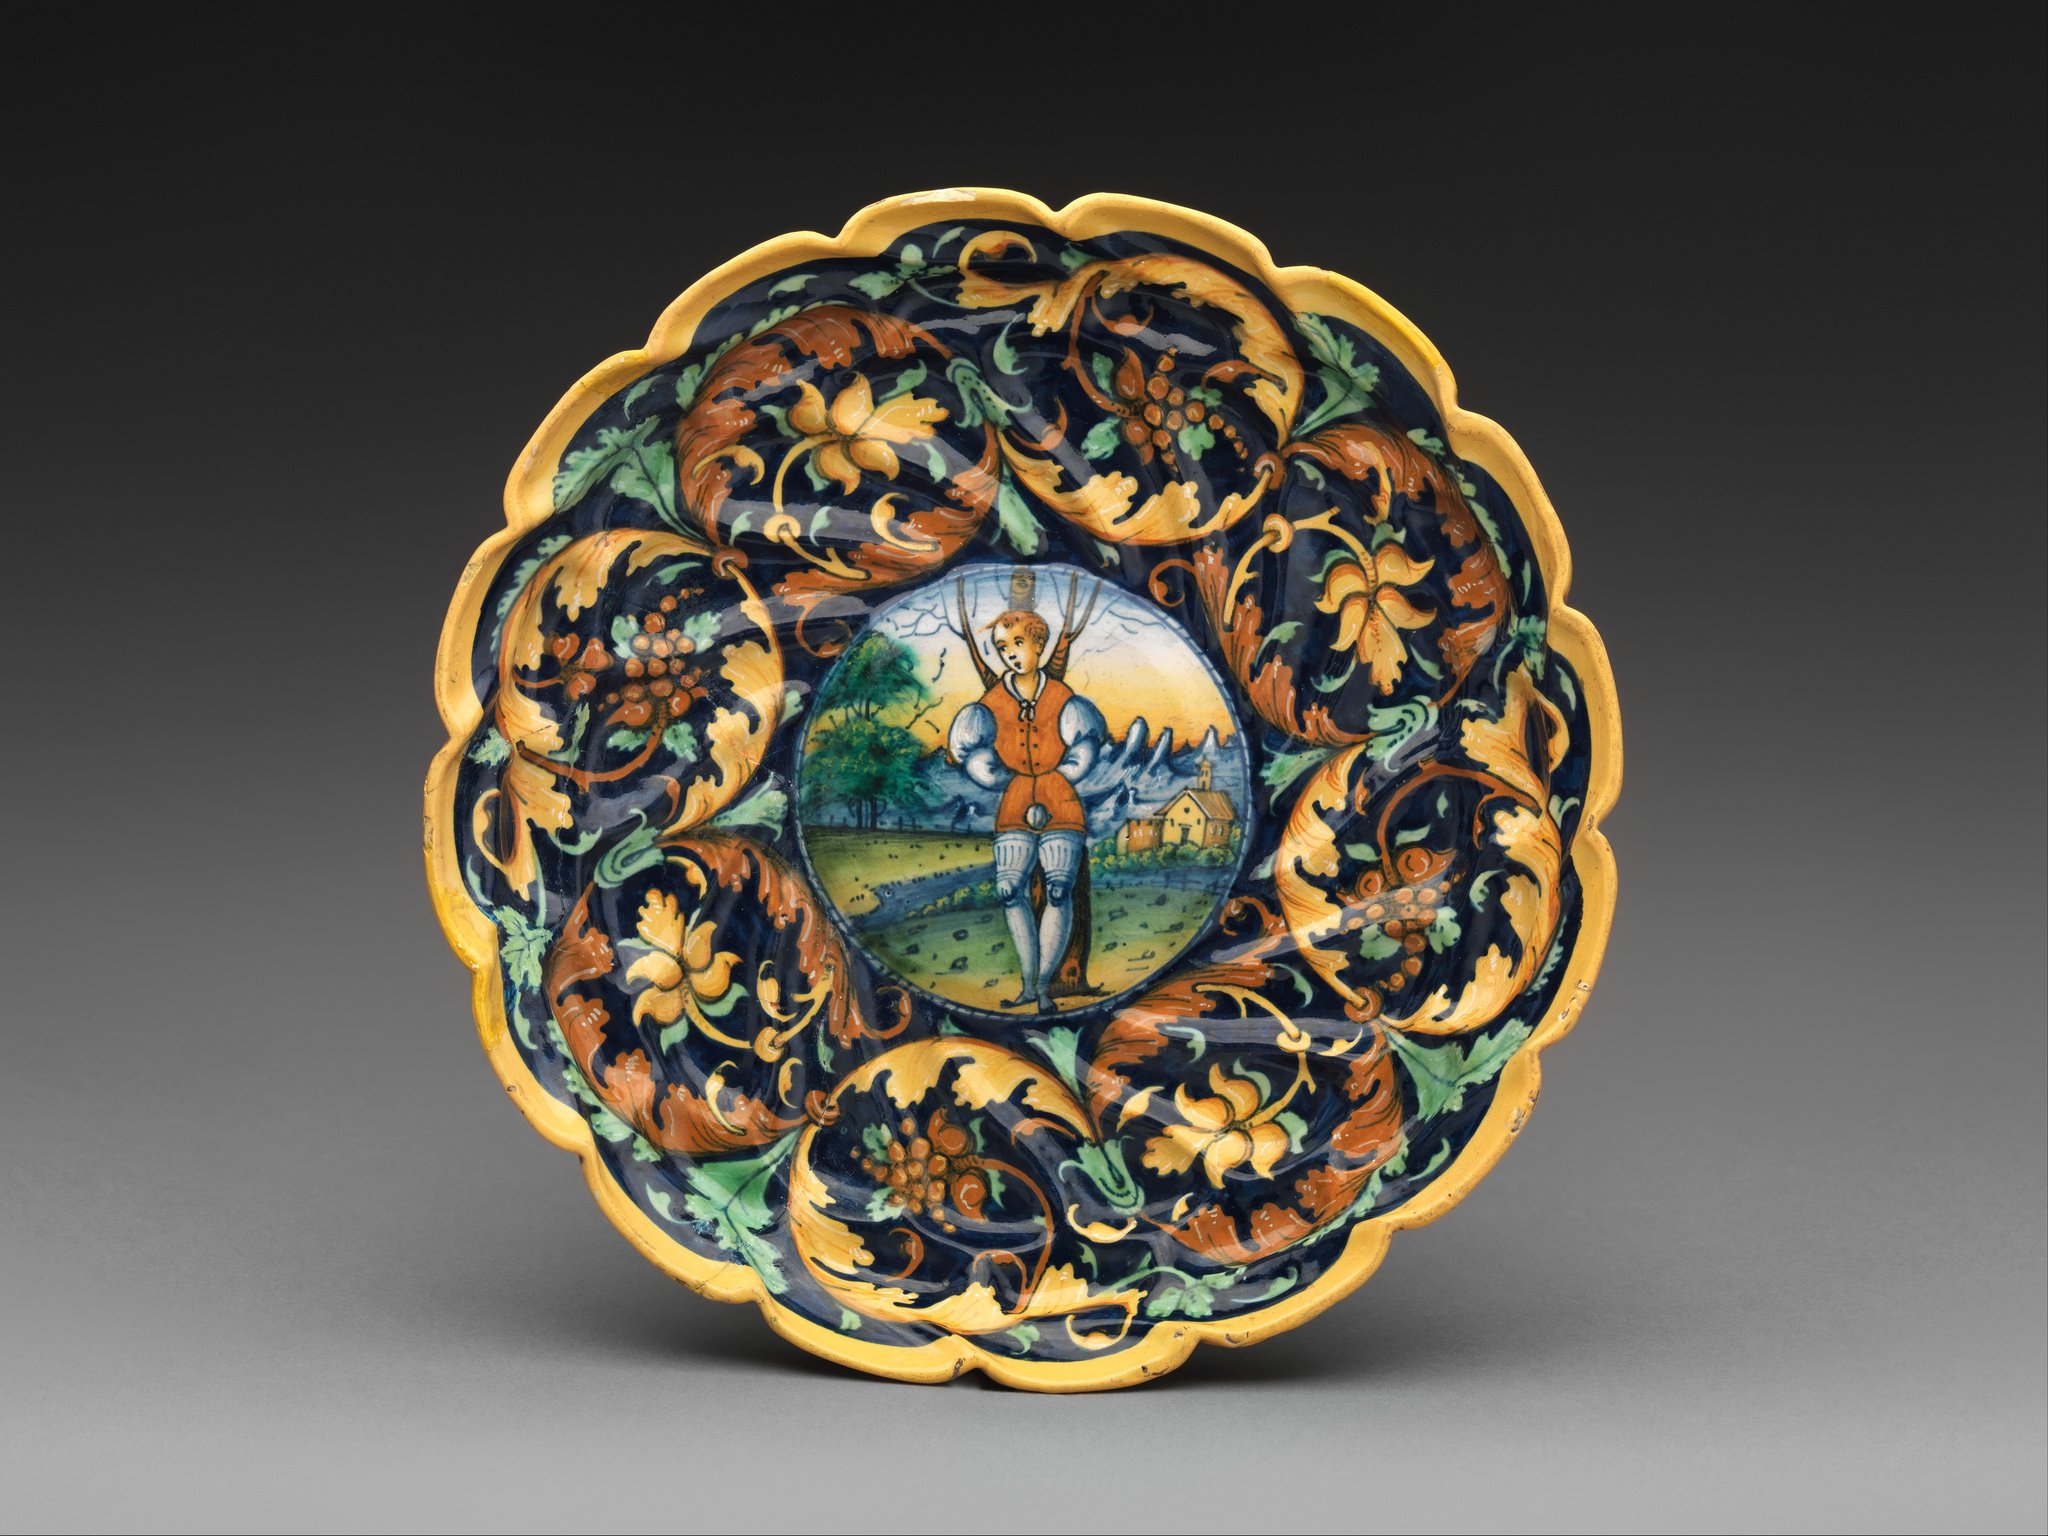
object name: bowl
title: Bowl with A Lover Tied to a Tree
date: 1535-1540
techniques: maiolica, glazing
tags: men,trees